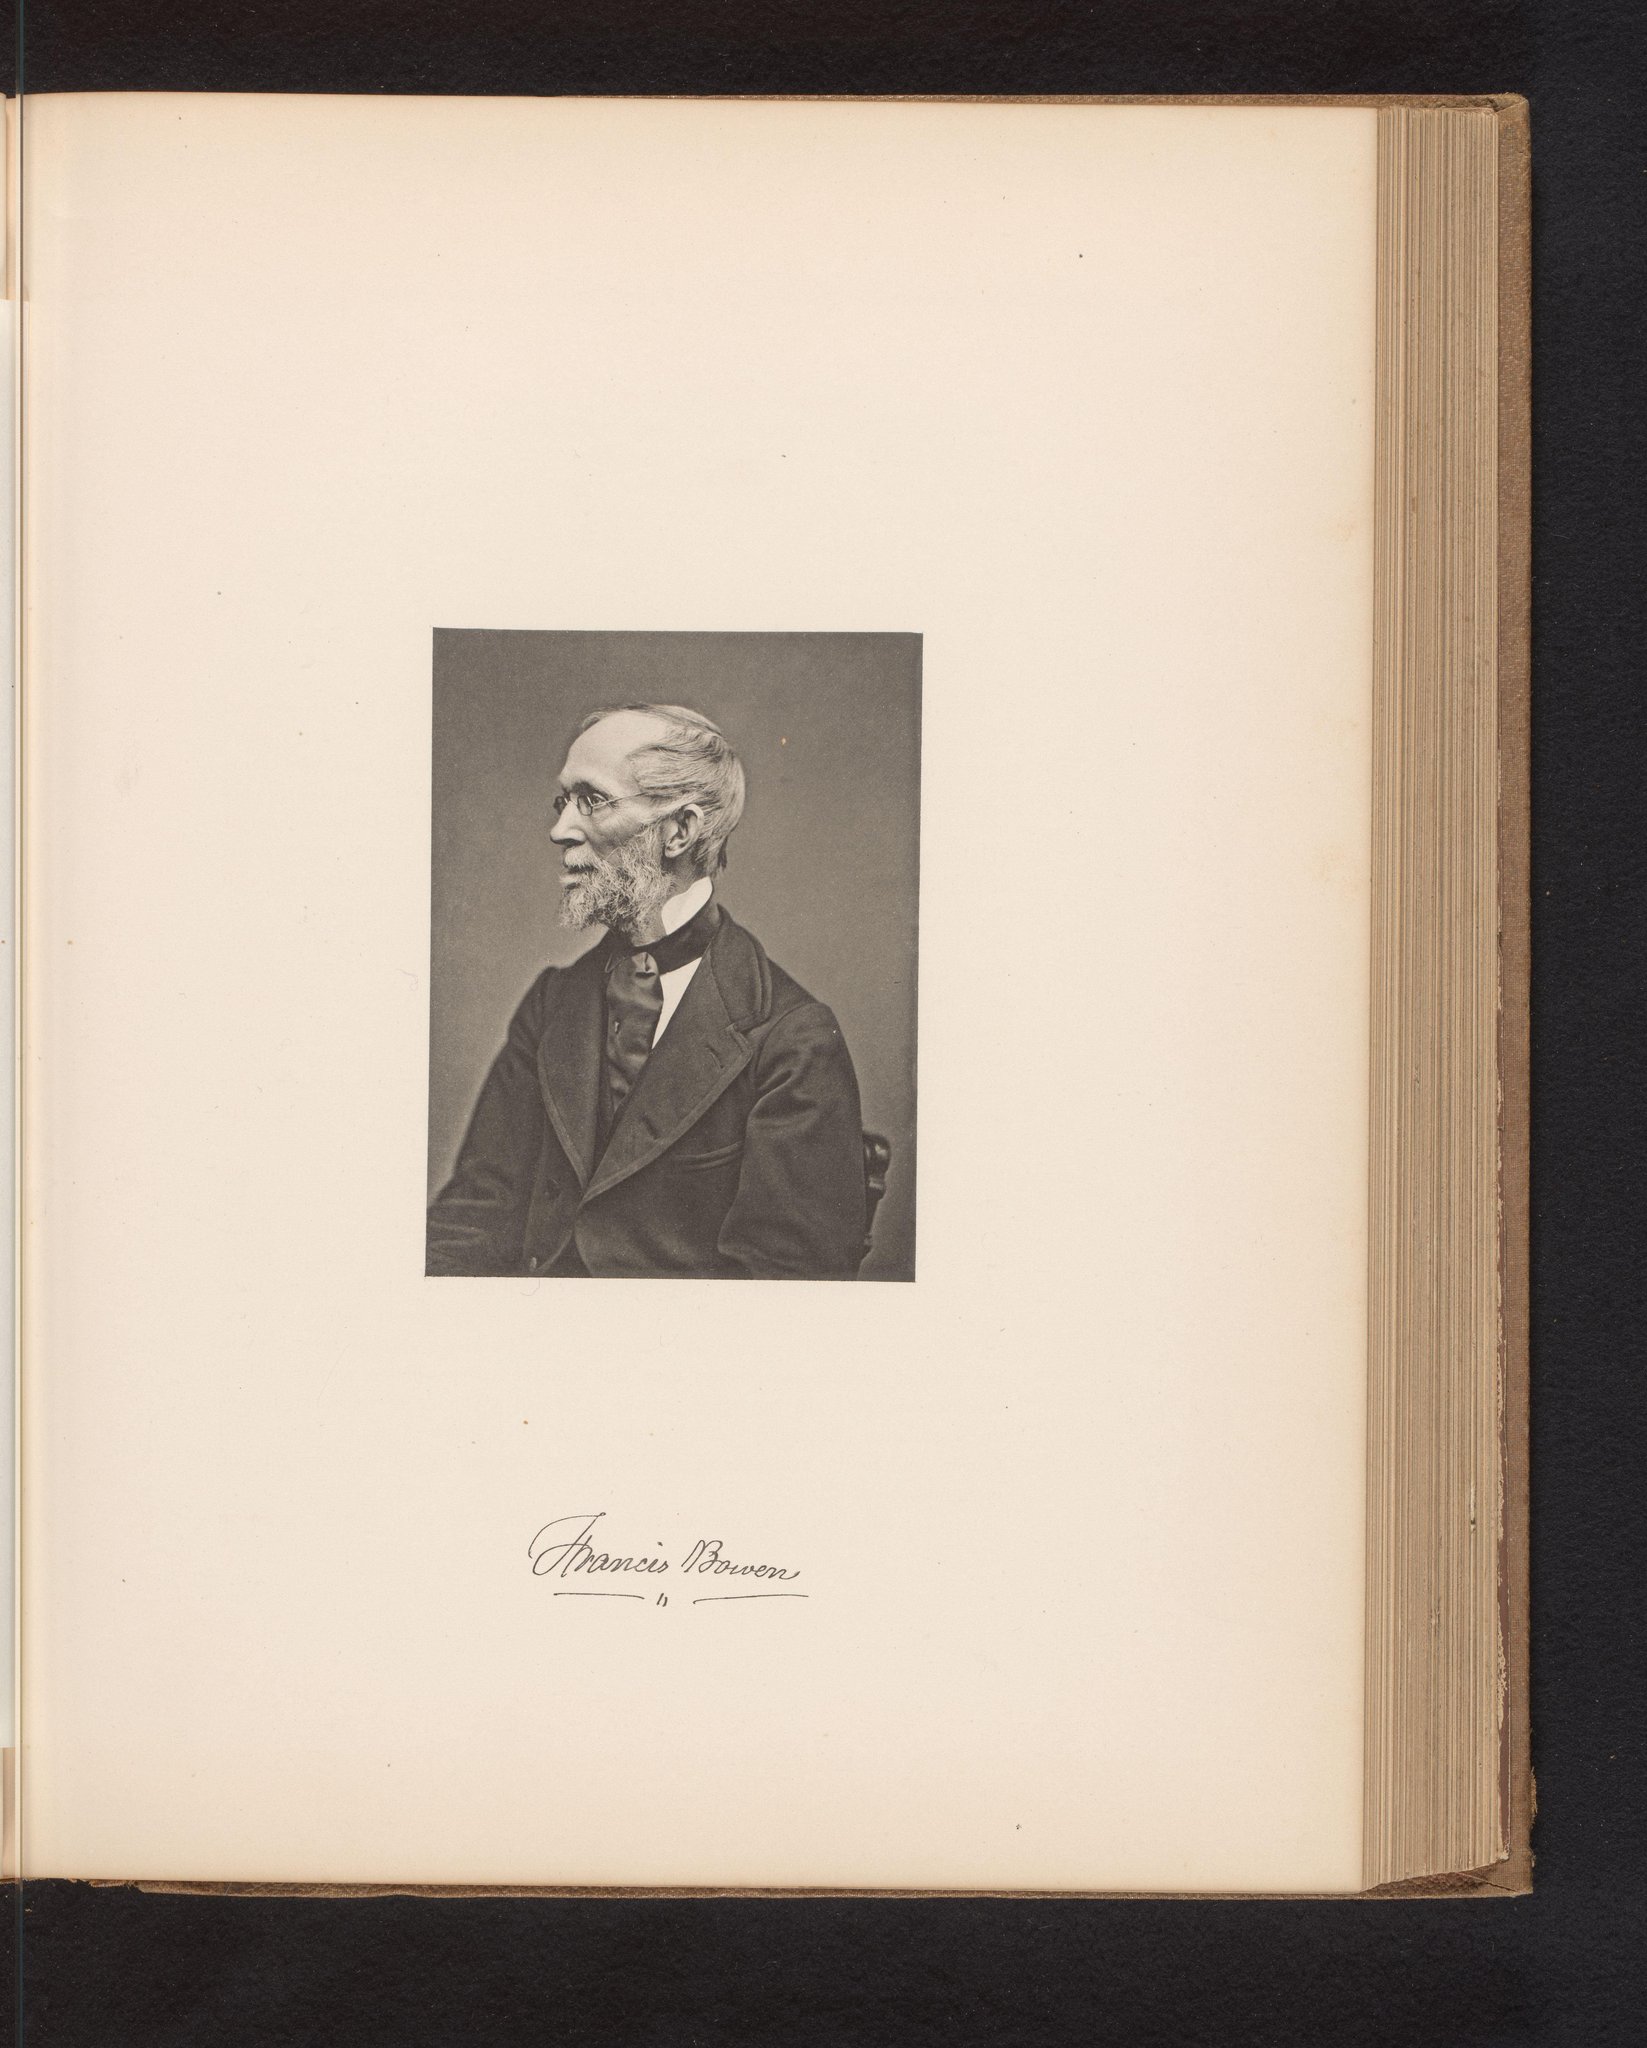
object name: page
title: Portret van Francis Bowen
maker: Anonymous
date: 1870-1875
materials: paper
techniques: photograph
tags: historical persons, scholar, philosopher (+ portrait of scholar, scientist)